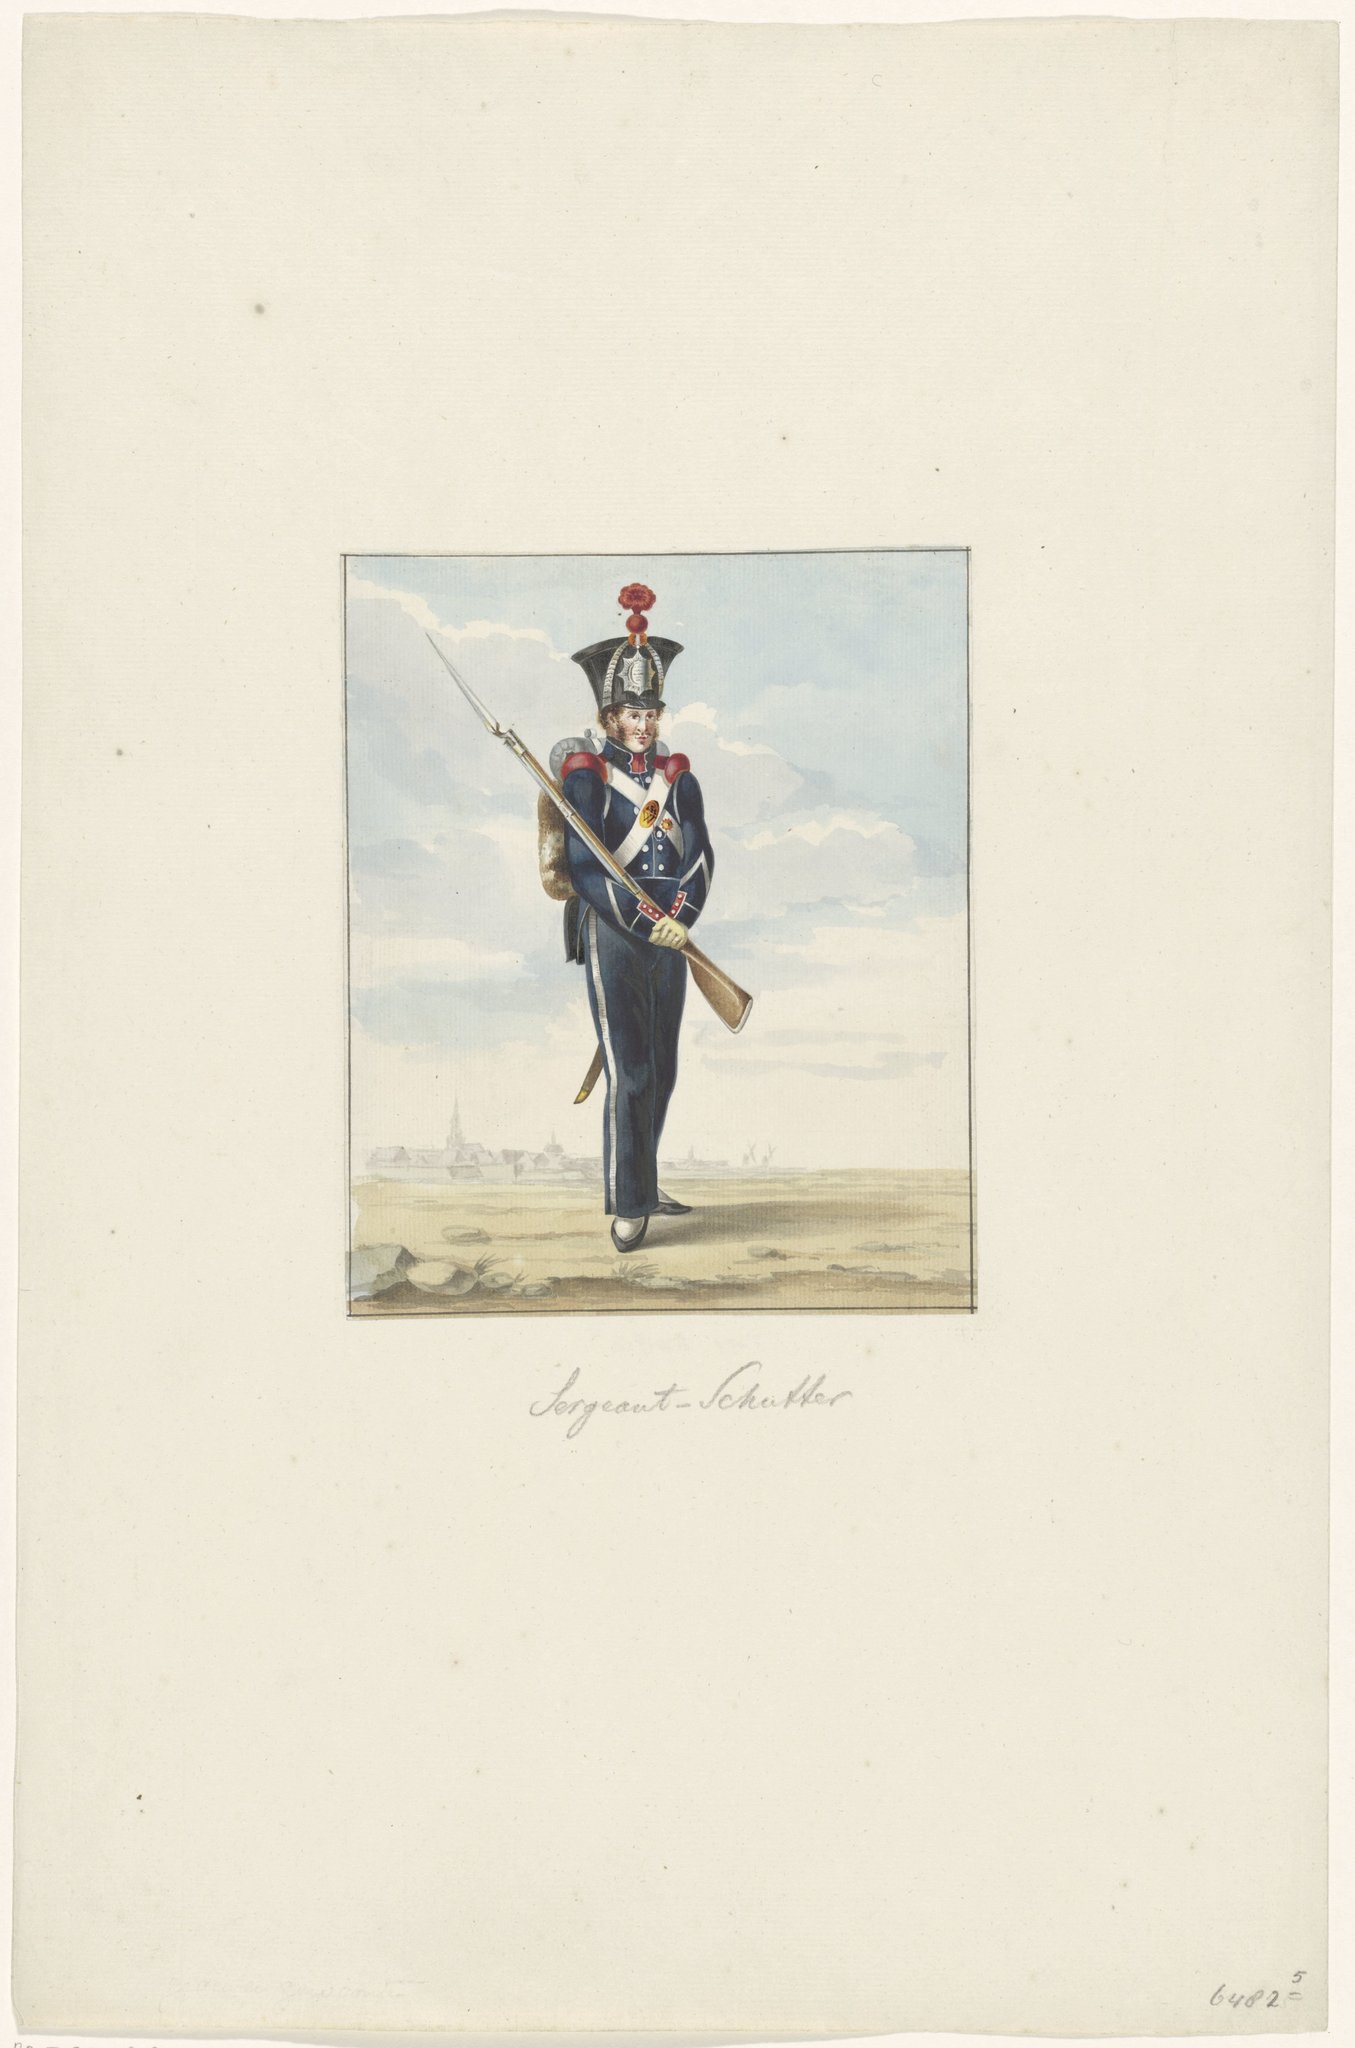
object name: drawing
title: Zes tekeningen van uniformen van het Nederlandse leger ca. 1830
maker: Anonymous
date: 1830-1831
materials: paper, pencil, watercolor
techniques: brush, pen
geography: netherlands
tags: (military) uniforms, clothes, costume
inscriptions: collector's mark: Lugt 2228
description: Uniform van een sergeant van de schutterij. Onderdeel van een serie van zes tekeningen van uniformen van het Nederlandse leger ca. 1830.